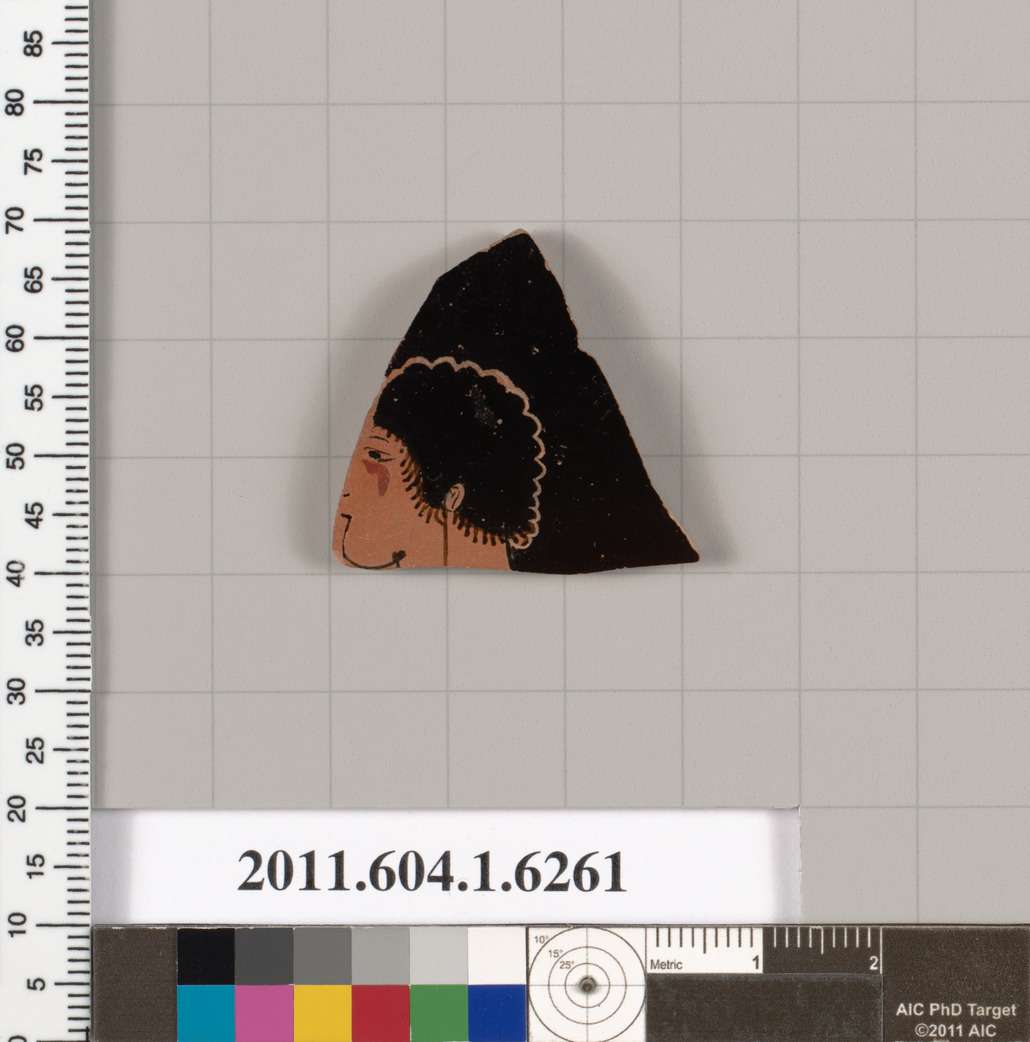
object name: kylix fragment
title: Terracotta fragment of a kylix (drinking cup)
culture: greek, attic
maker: onesimos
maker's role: artist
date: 500-480 BCE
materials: terracotta